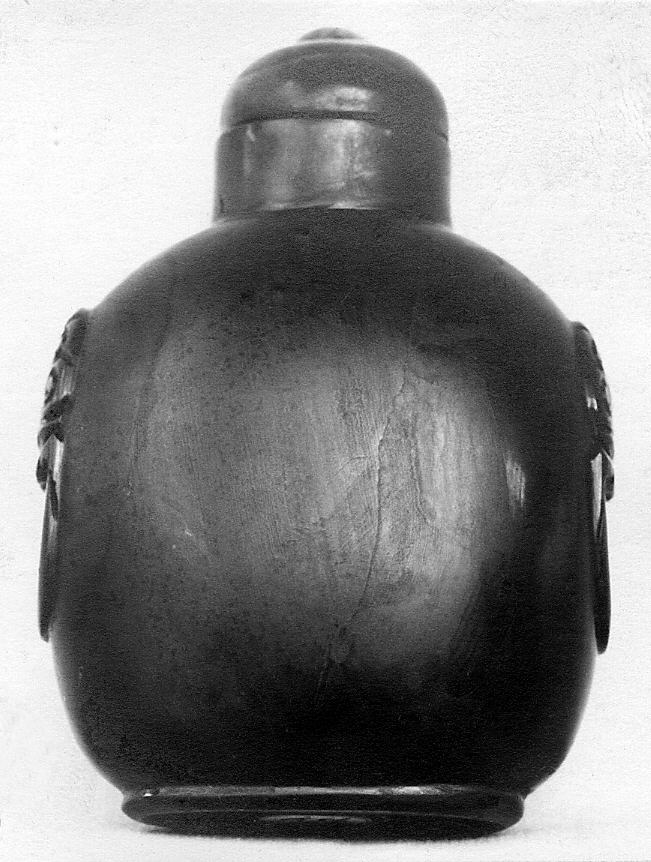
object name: snuff bottle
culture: chinese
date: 1767-1833